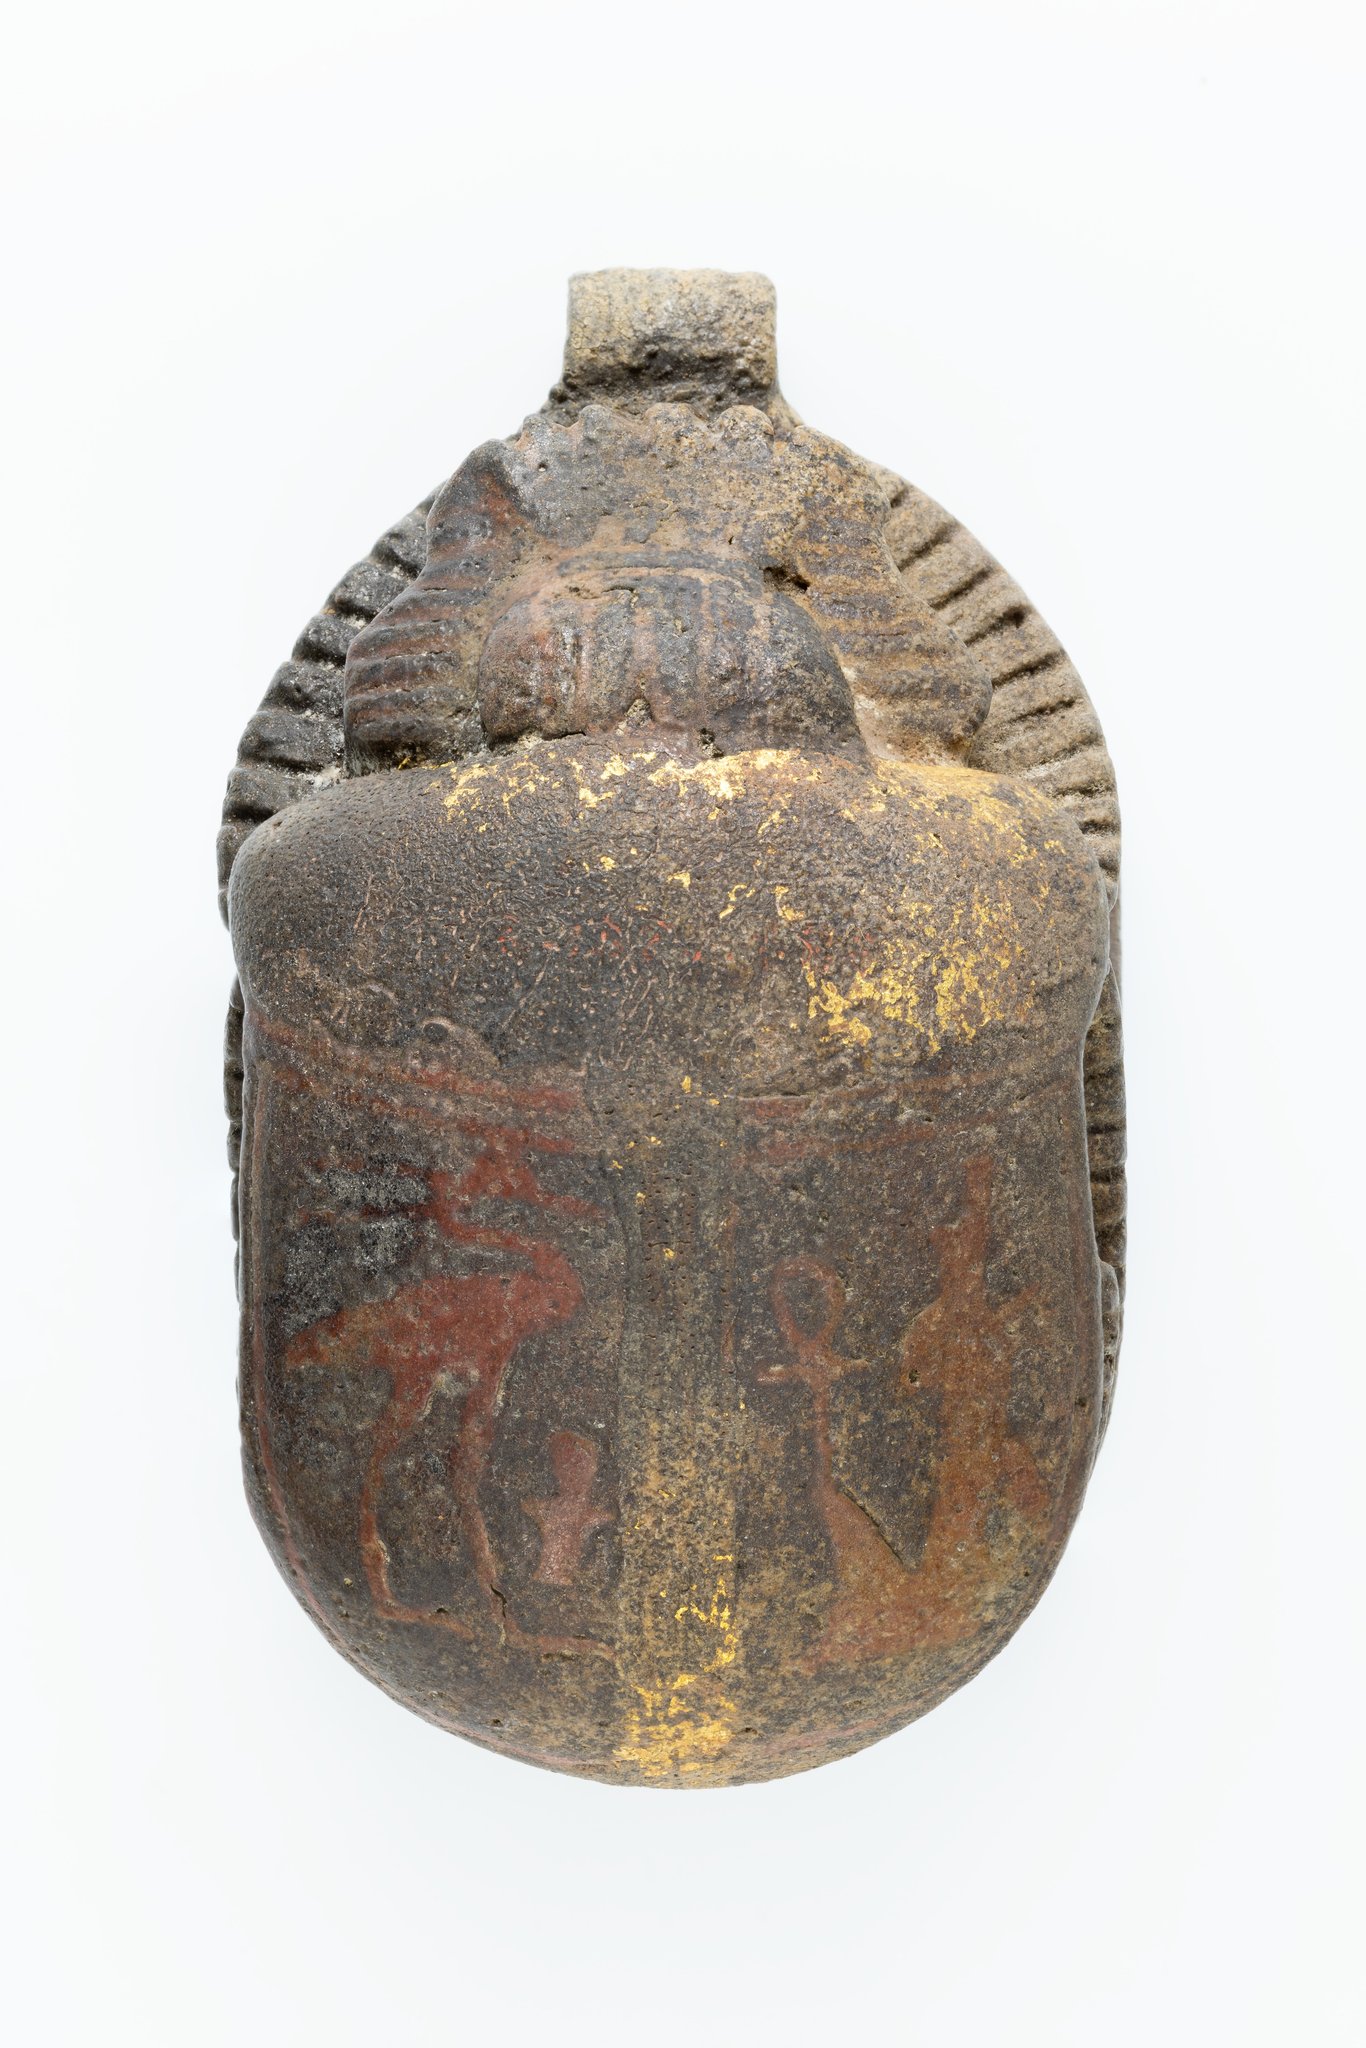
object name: heart scarab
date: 1070-664 BCE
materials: faience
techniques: inlay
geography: egypt